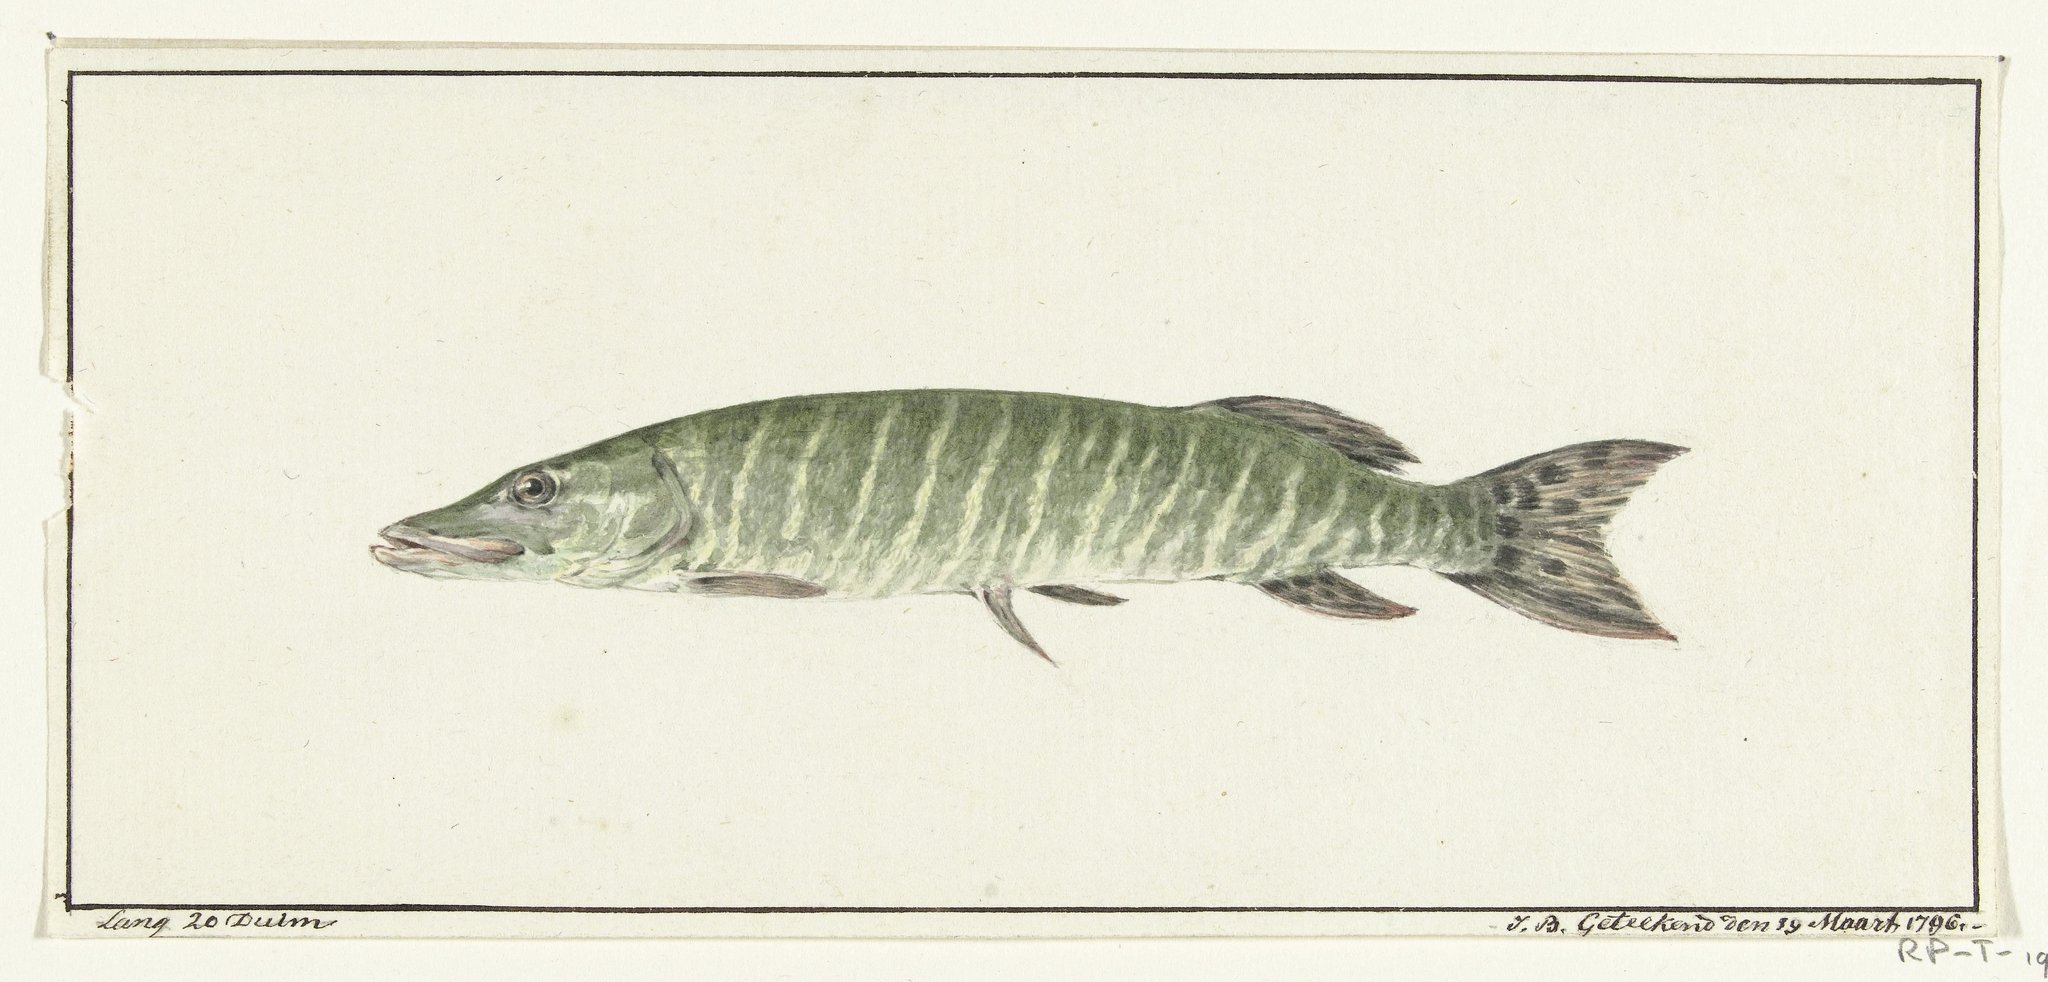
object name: watercolor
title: Snoek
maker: jean bernard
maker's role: draughtsman, print maker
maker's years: 1765-1833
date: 1796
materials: chalk, ink, paper, watercolor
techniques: brush, pen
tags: bony fishes: pike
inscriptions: : ‘Lang 20 Duim’